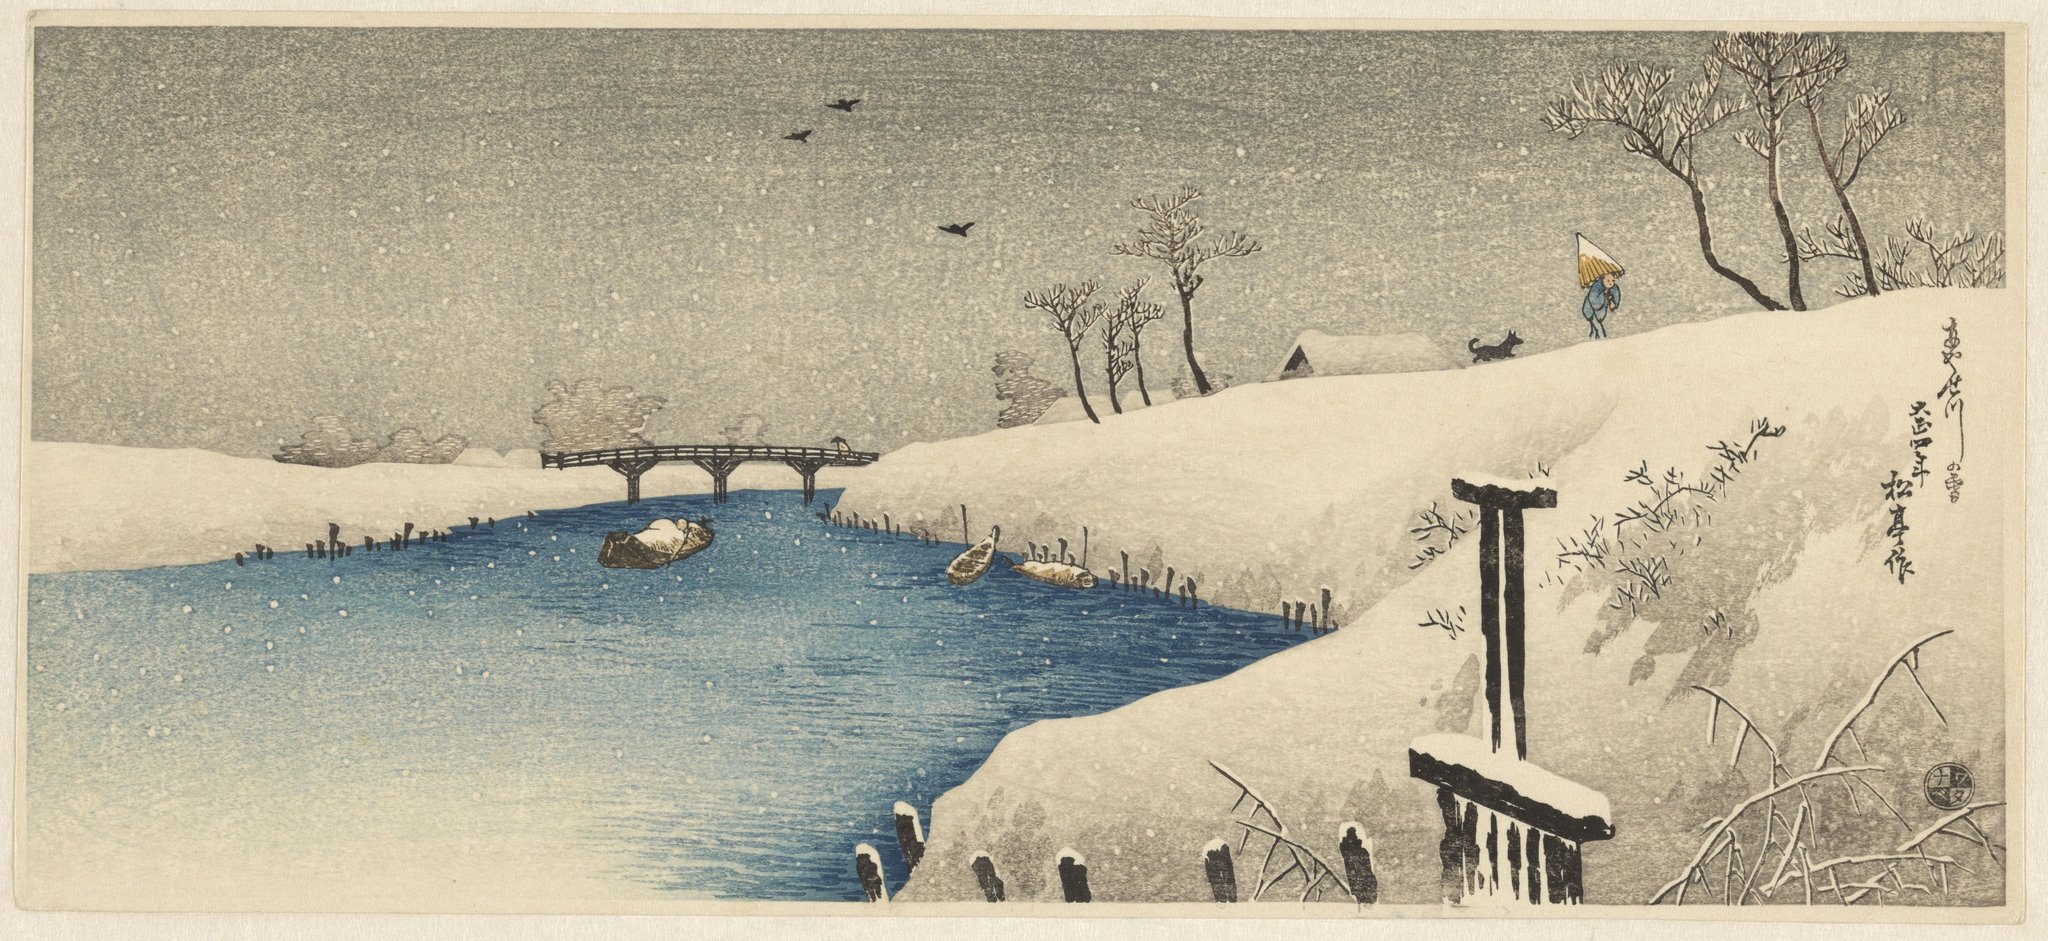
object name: print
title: Snow on Ayase river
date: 1915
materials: paper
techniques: woodcut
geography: japan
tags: river, snow